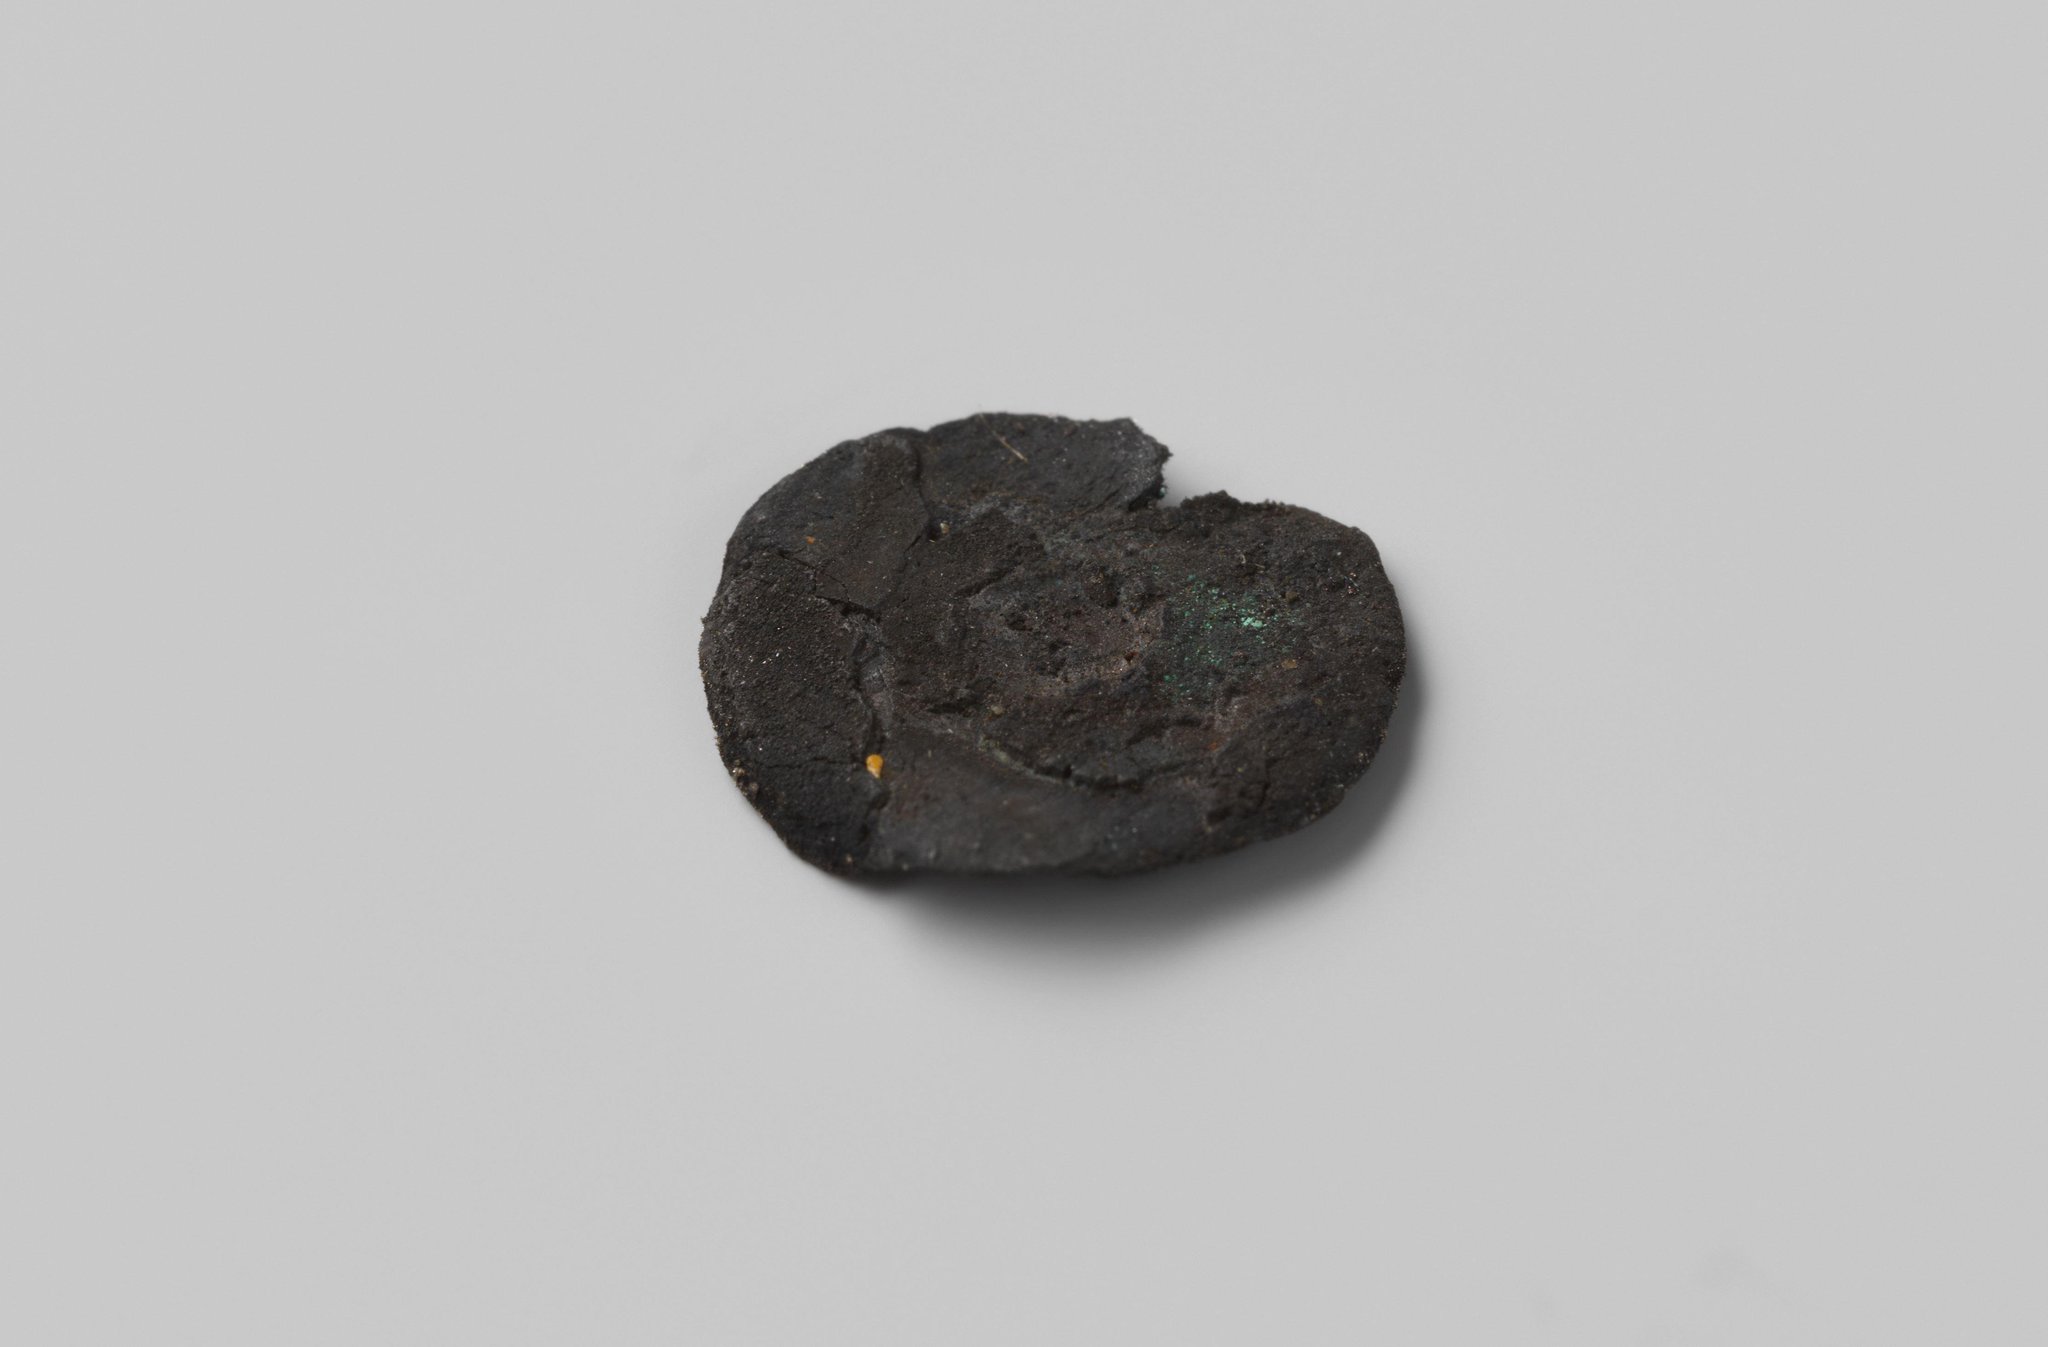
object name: fragment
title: Schijfvormig fragment uit het wrak van de Oost-Indiëvaarder Hollandia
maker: Anonymous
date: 1700-1743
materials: silver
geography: netherlands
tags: verenigde oostindische compagnie, hollandia (schip), annet